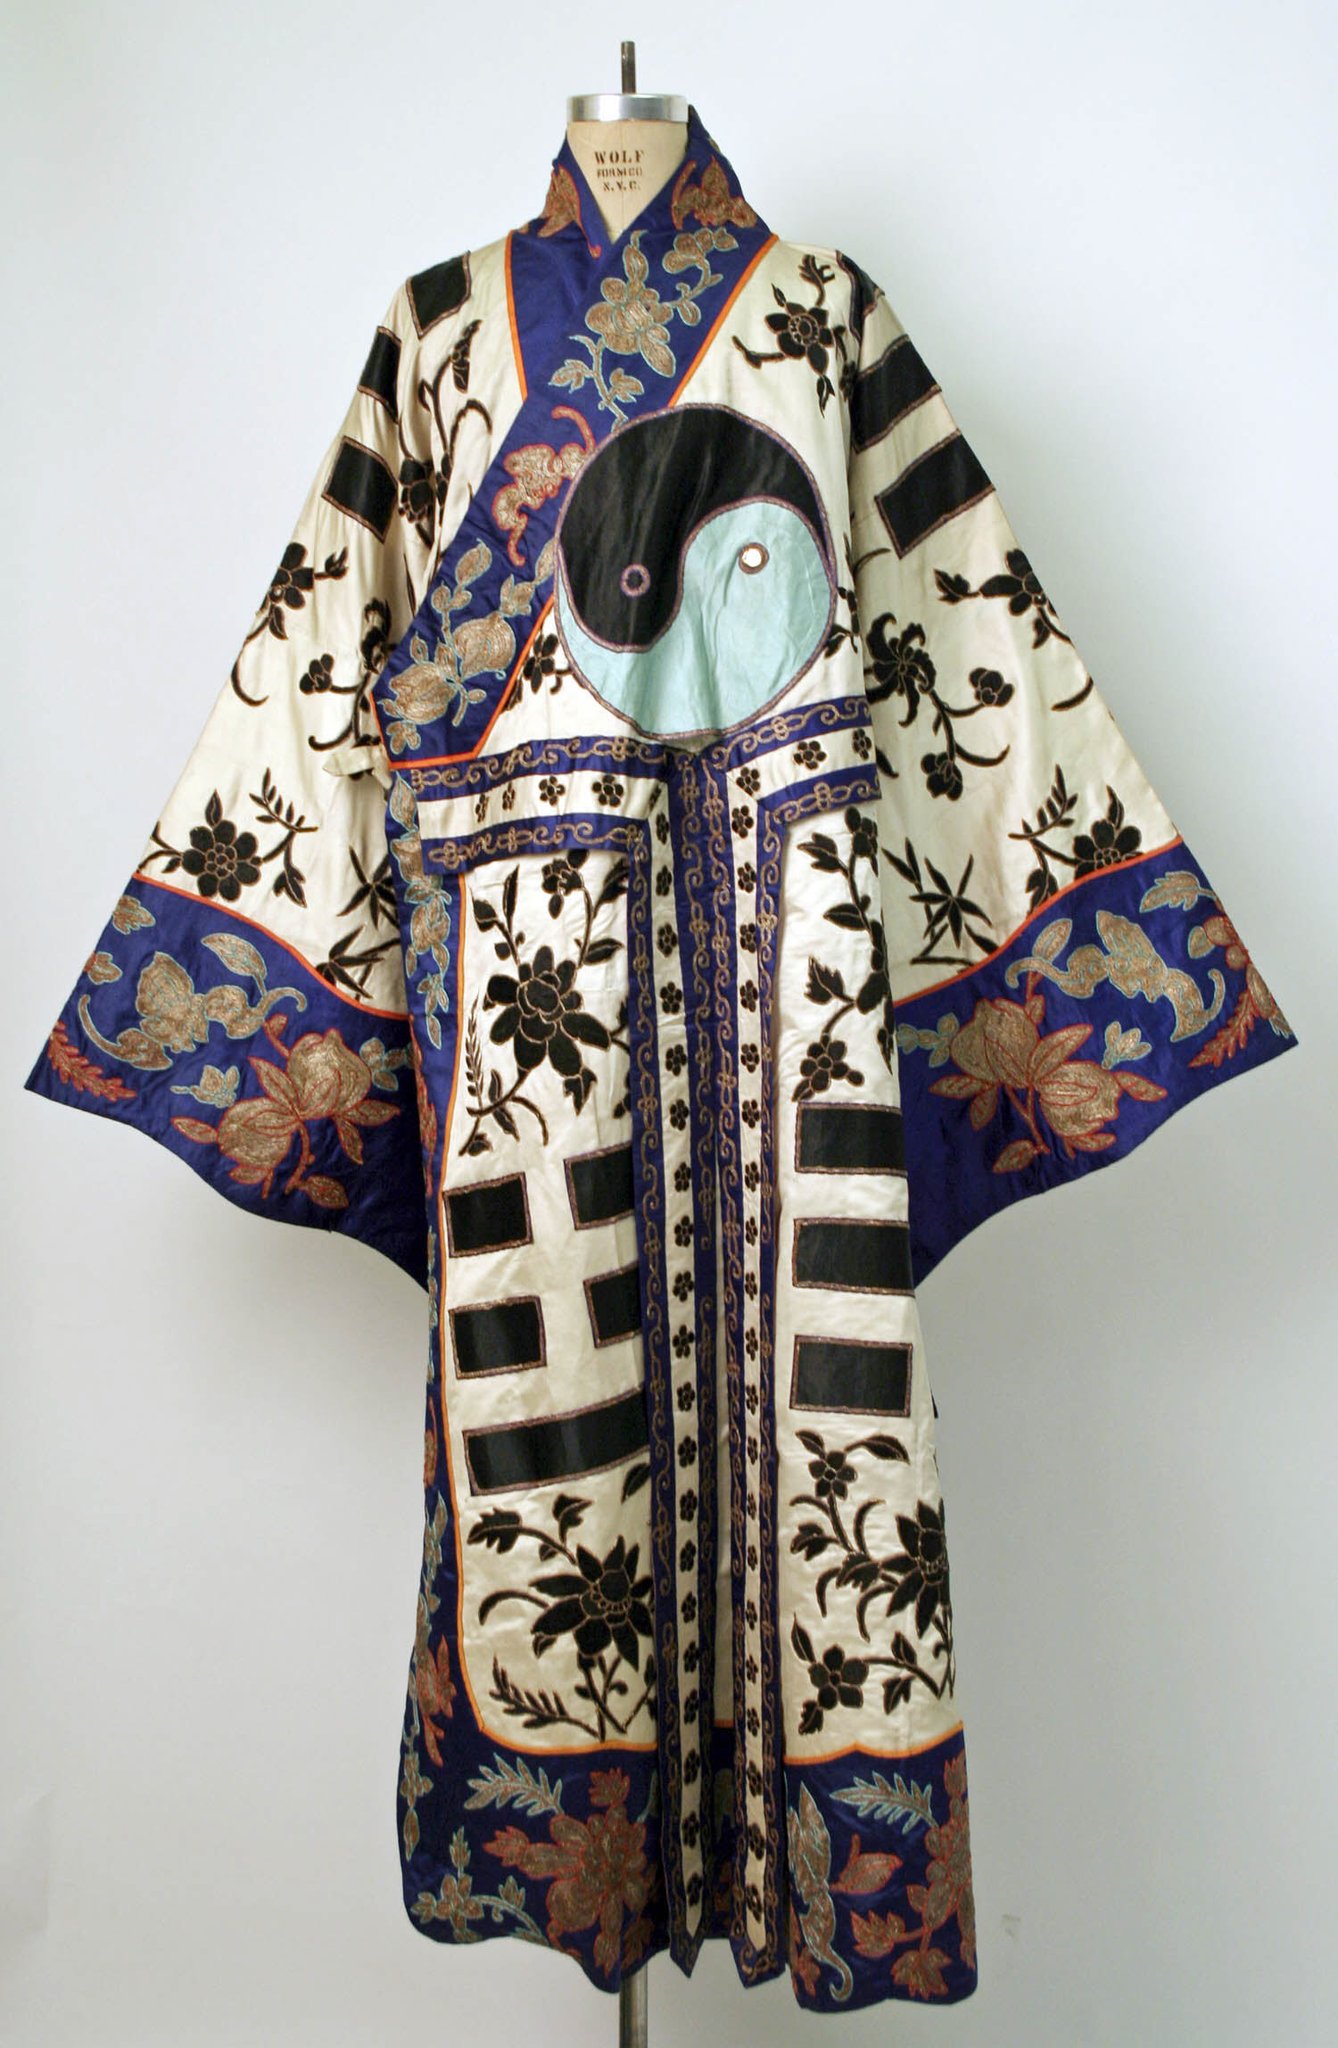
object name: theatrical costume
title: Theatrical robe with eight trigrams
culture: chinese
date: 1867-1900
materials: metal thread, silk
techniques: embroidery